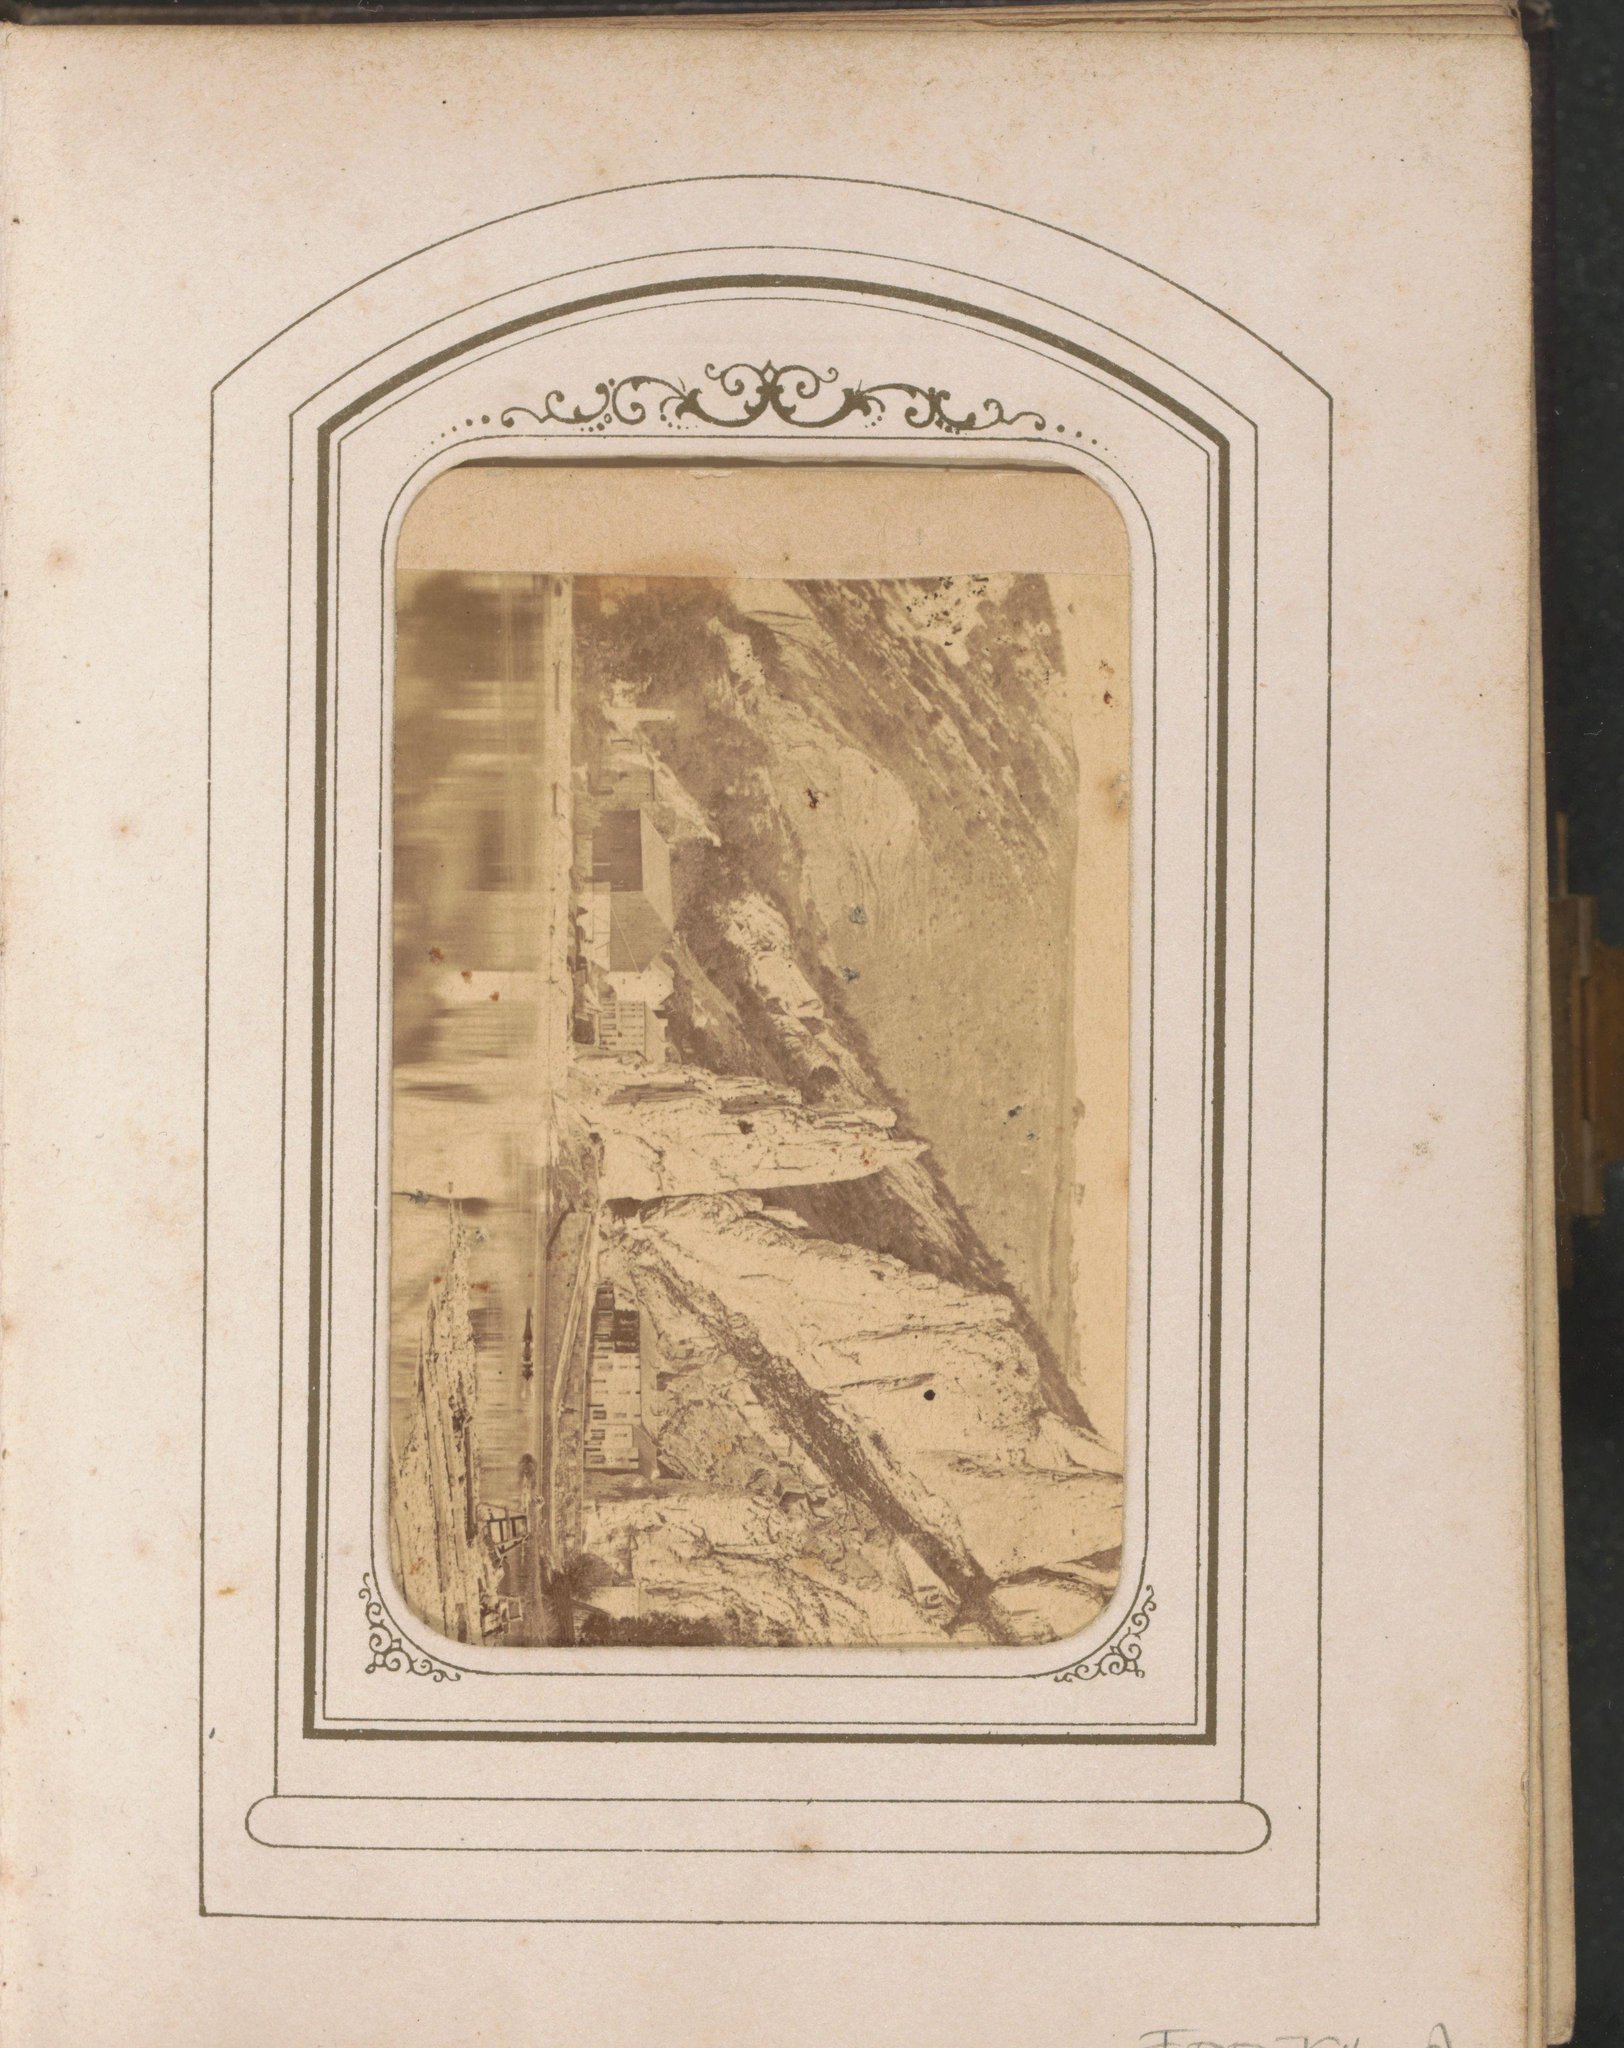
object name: carte de visite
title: Rotsformatie Ros Beiaard aan de Maas in Dinant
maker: jules hallez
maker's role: fotograaf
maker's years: 1829-1894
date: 1860-1890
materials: cardboard, paper, photographic support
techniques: albumen print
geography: dinant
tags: travelling; tourism, rock-formations, prospect of city, town panorama, silhouette of city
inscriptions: inscription: ‘Rocher de Baijard Dinant’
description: Onderdeel van Fotoalbum met 36 opnames van Europese landen.